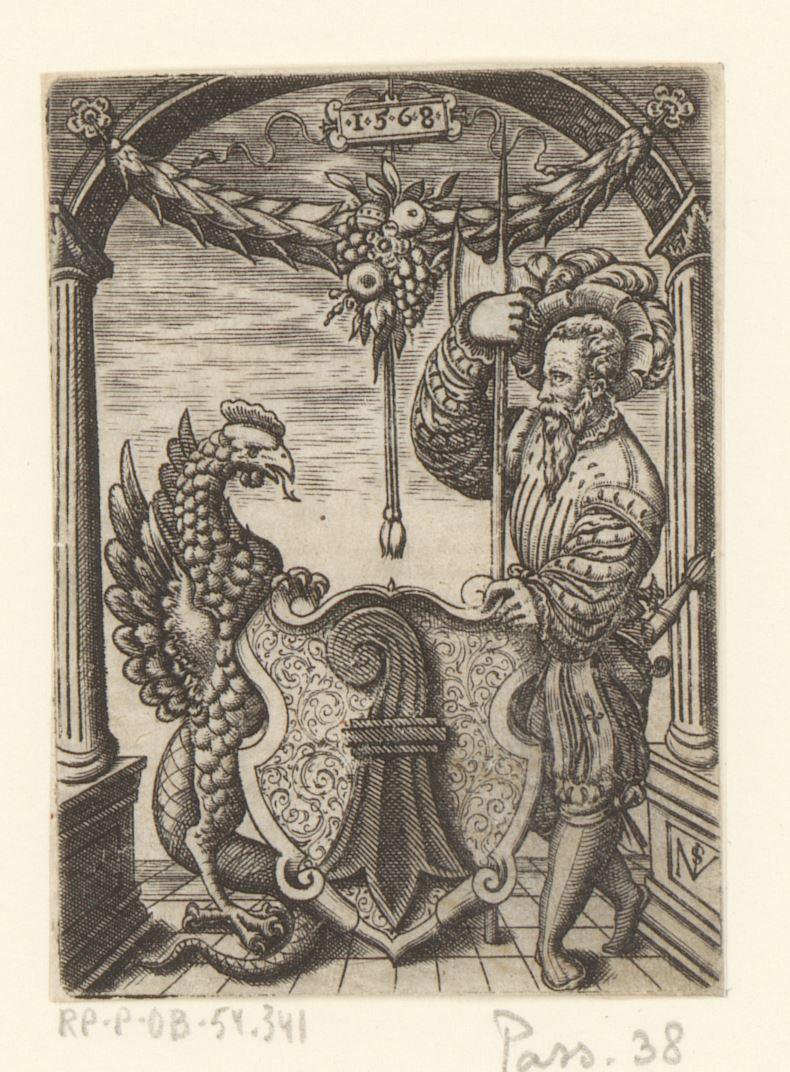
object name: print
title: Stadswapen van Bazel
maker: nikolaus solis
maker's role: print maker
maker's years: 1542-1584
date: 1568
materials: paper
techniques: engraving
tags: dragon, the soldier; the soldier's life, armorial bearing, heraldry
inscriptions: collector's mark: Lugt 2228